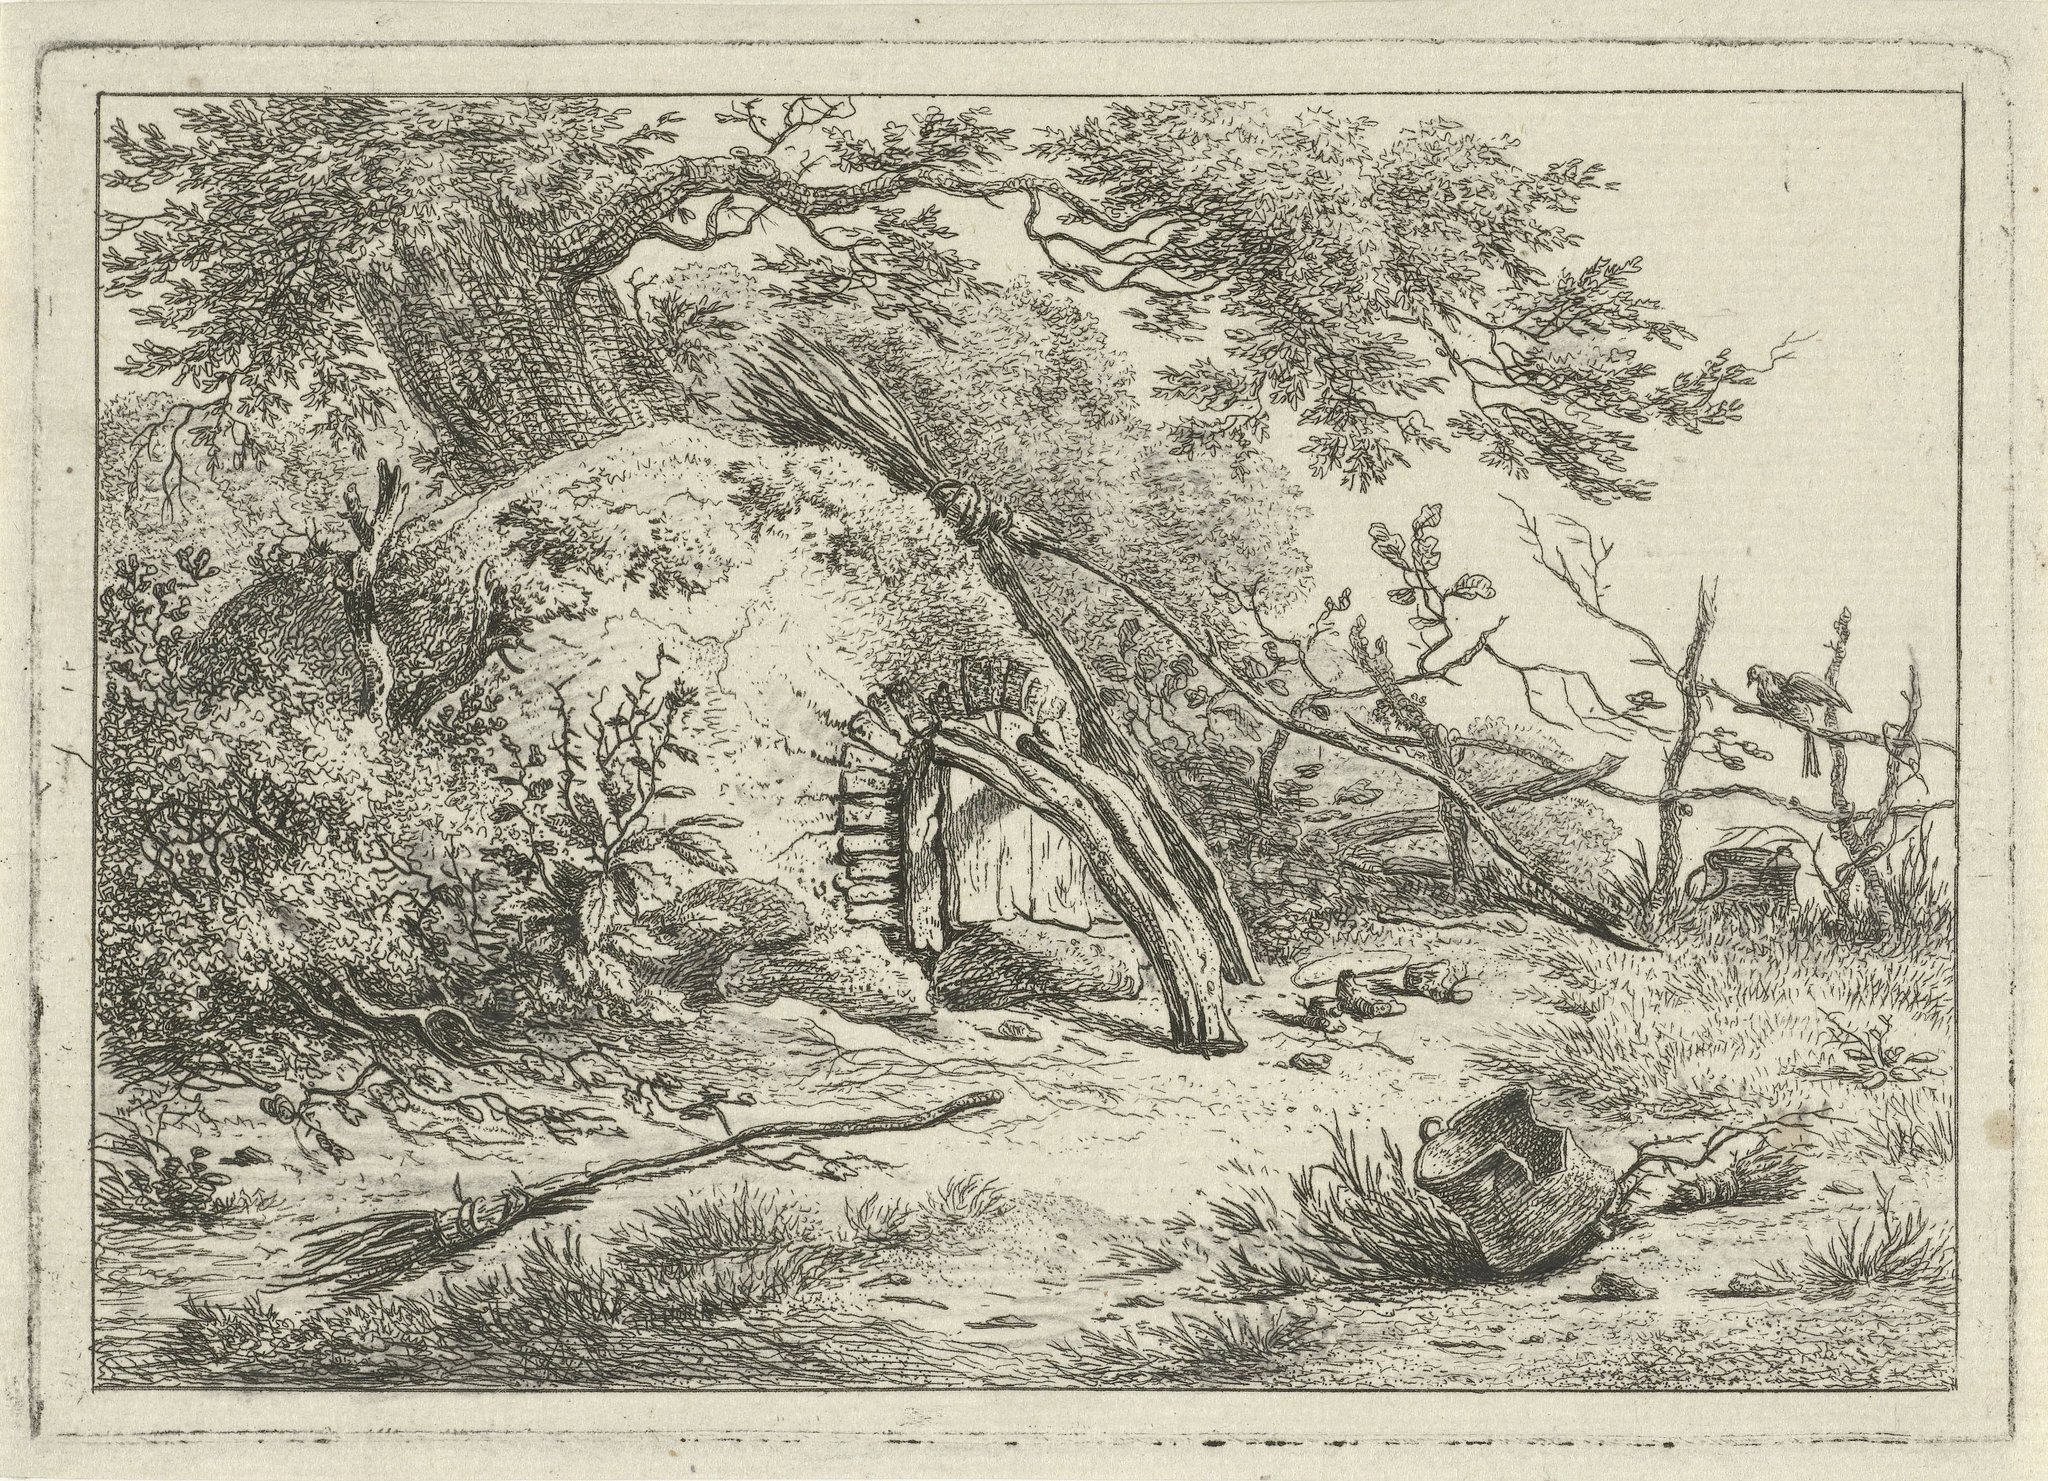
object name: print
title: Oven met bezems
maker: hermanus fock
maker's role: conservator, draughtsman, painter, print maker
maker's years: 1766-1822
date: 1809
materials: paper, pencil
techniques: etching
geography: amsterdam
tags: oven ~ kitchen - cc - in the open air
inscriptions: collector's mark: Lugt 2228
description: Een gezicht op een halfronde oven bij een boom. Tegen de oven staat een bezem; een tweede bezem ligt op de grond. De deur van de oven is afgesloten met een gebogen boomstam.